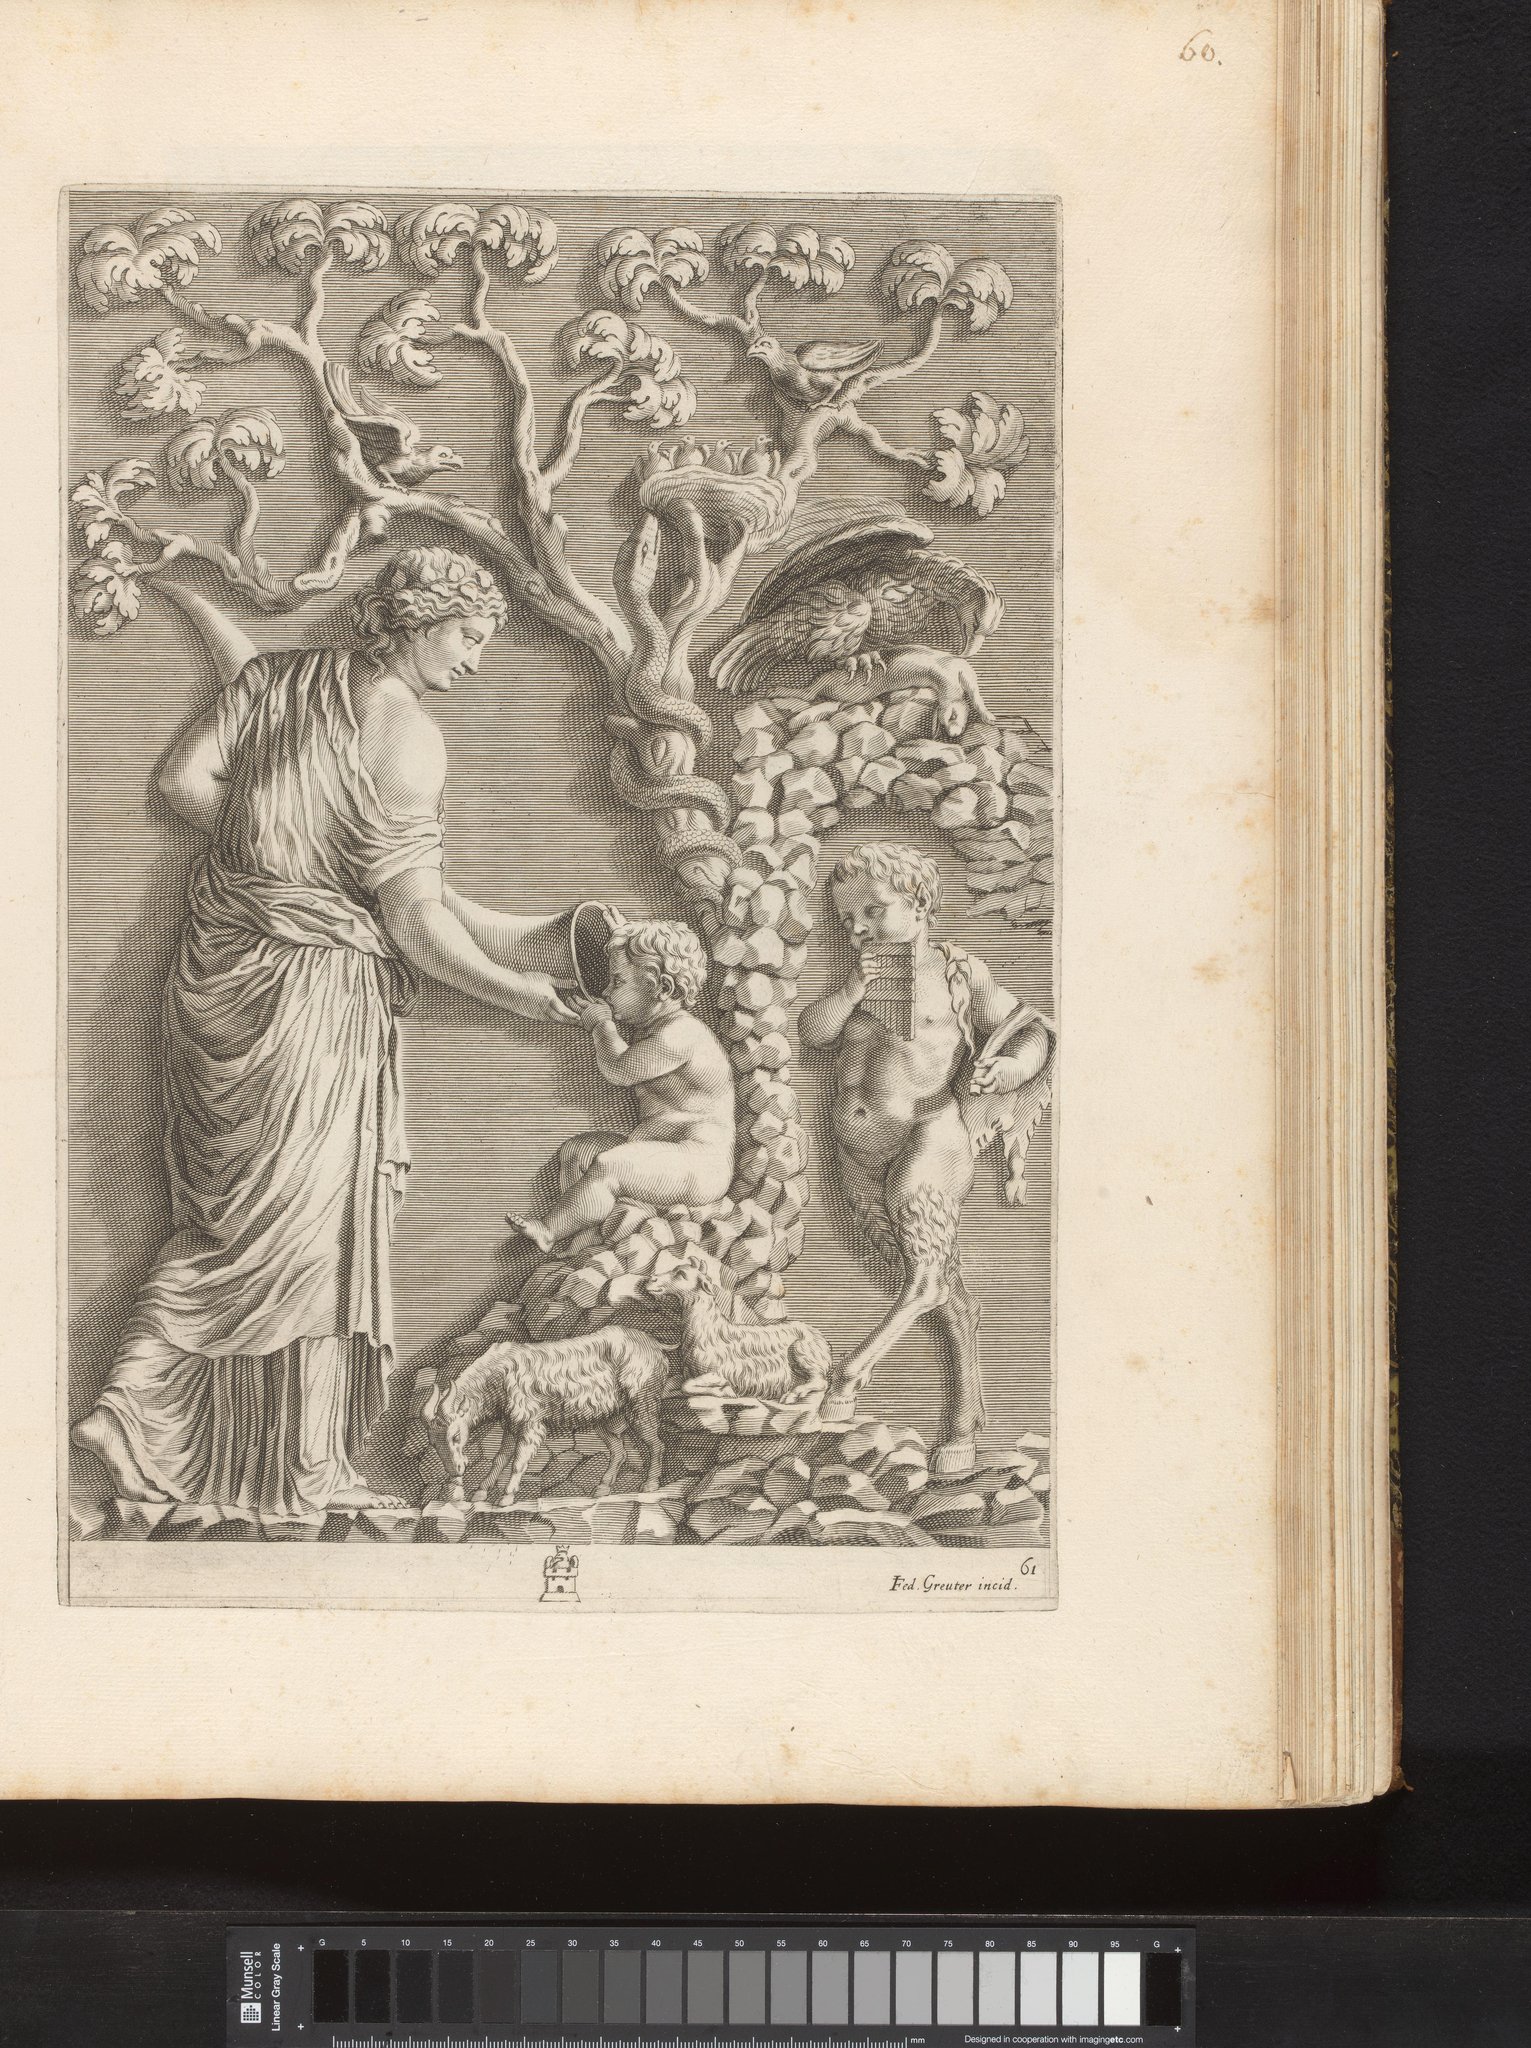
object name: album leaf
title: Galleria Giustiniana del Marchese Vincenzo Giustiniani II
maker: valérien regnard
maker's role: print maker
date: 1636-1647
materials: paper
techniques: engraving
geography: rome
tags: vestal virgin(s), column, pillar ~ architecture, piece of sculpture, reproduction of a piece of sculpture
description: Bas-reliëf met twee Vestaalse maagden, die naar een tempel gaan. Midden onder het wapenschild van Vincenzo Giustiniani, die dit bas-reliëf in zijn bezit had. Prent maakt deel uit van een album met een serie prenten naar de sculpturen in de verzameling in de Galleria Giustiniani te Rome.